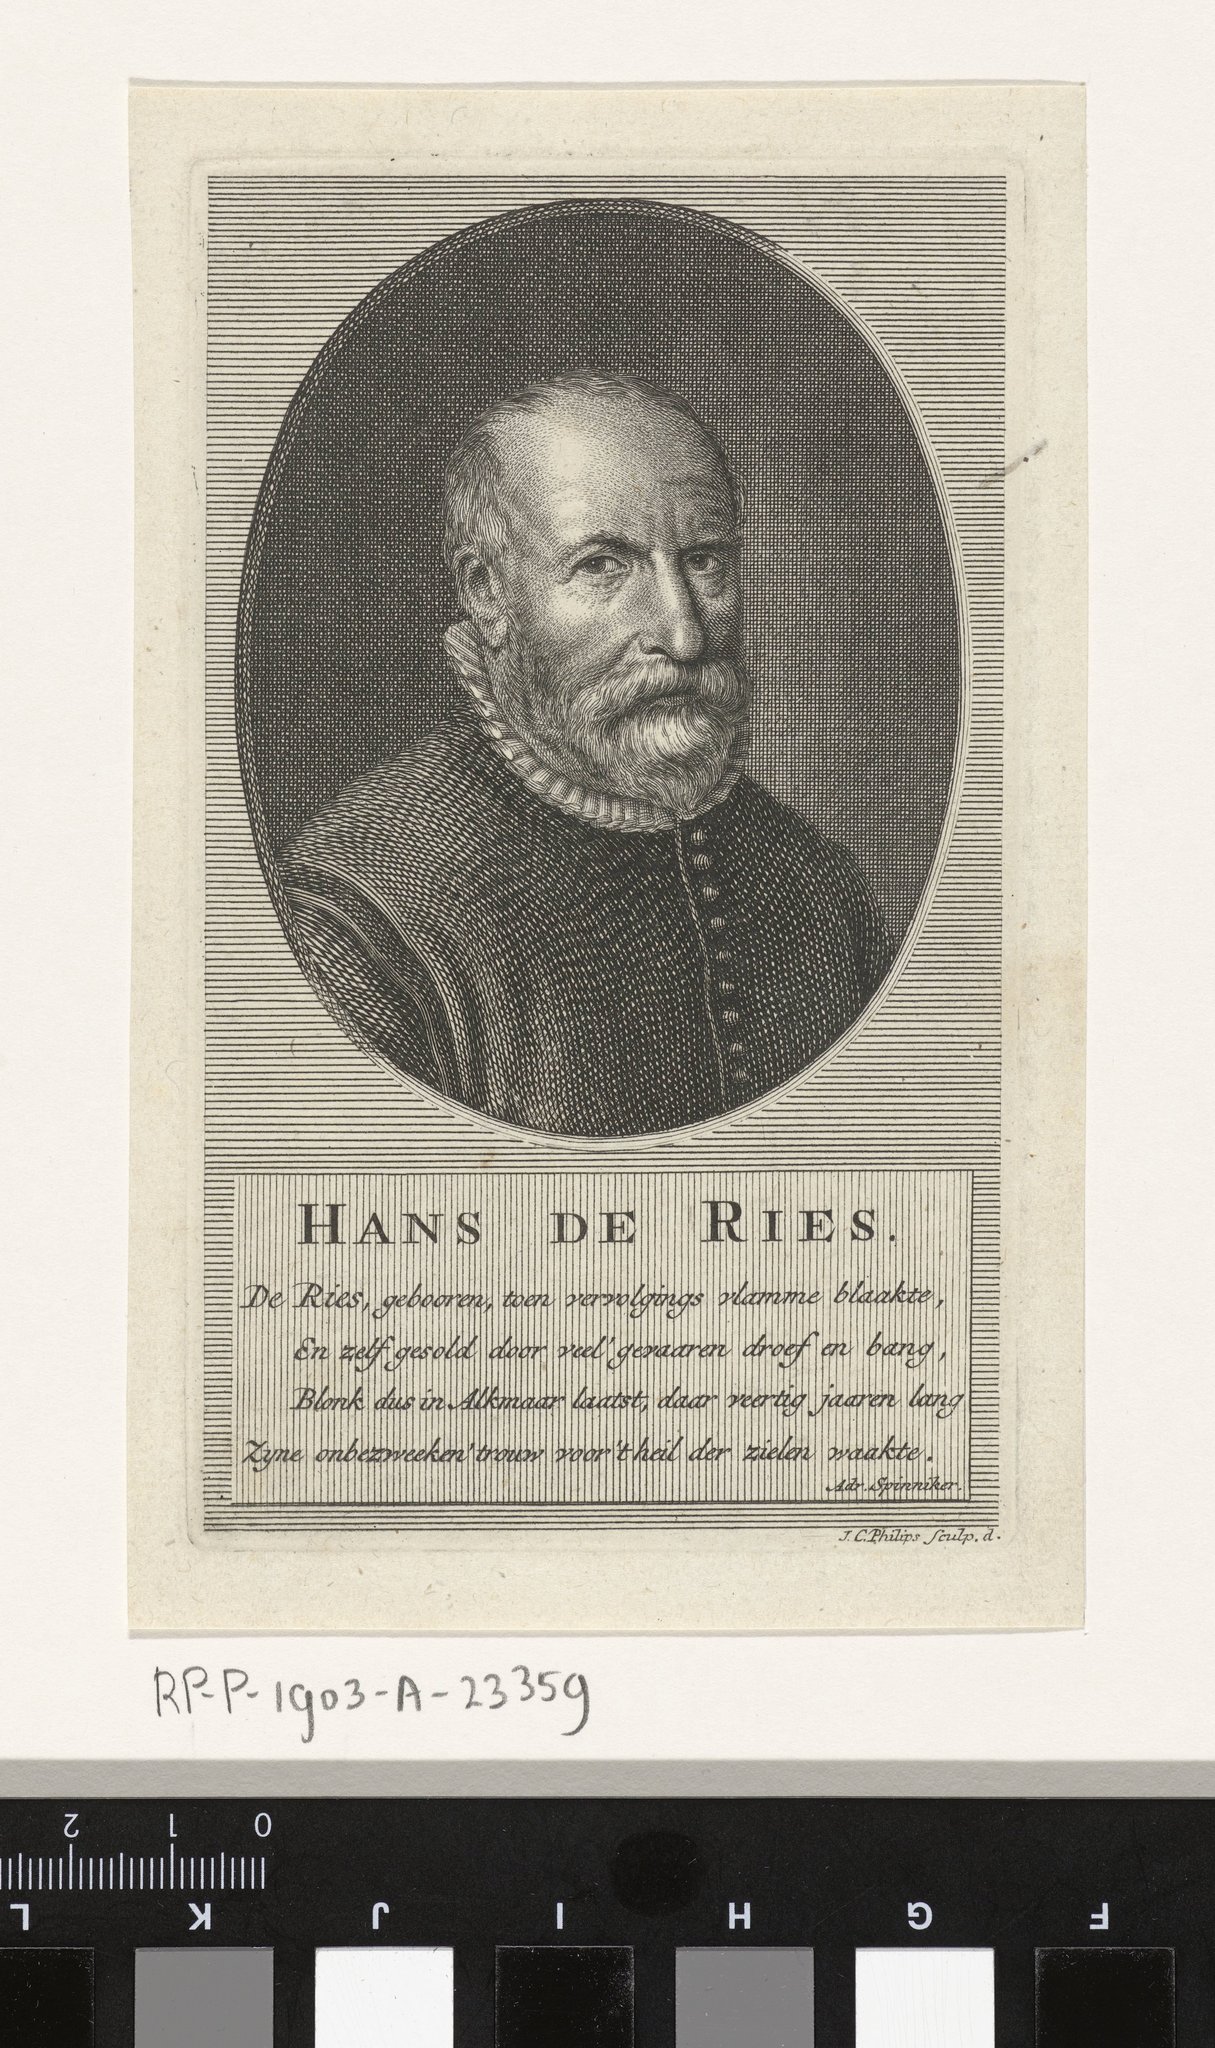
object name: print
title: Portret van de doopsgezinde predikant Hans de Ries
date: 1736-1743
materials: paper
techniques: engraving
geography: amsterdam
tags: antwerp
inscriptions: collector's mark: Lugt 2228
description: Portret van de doopsgezinde predikant Hans de Ries. In het kader een vierregelig lofdicht in het Nederlands.